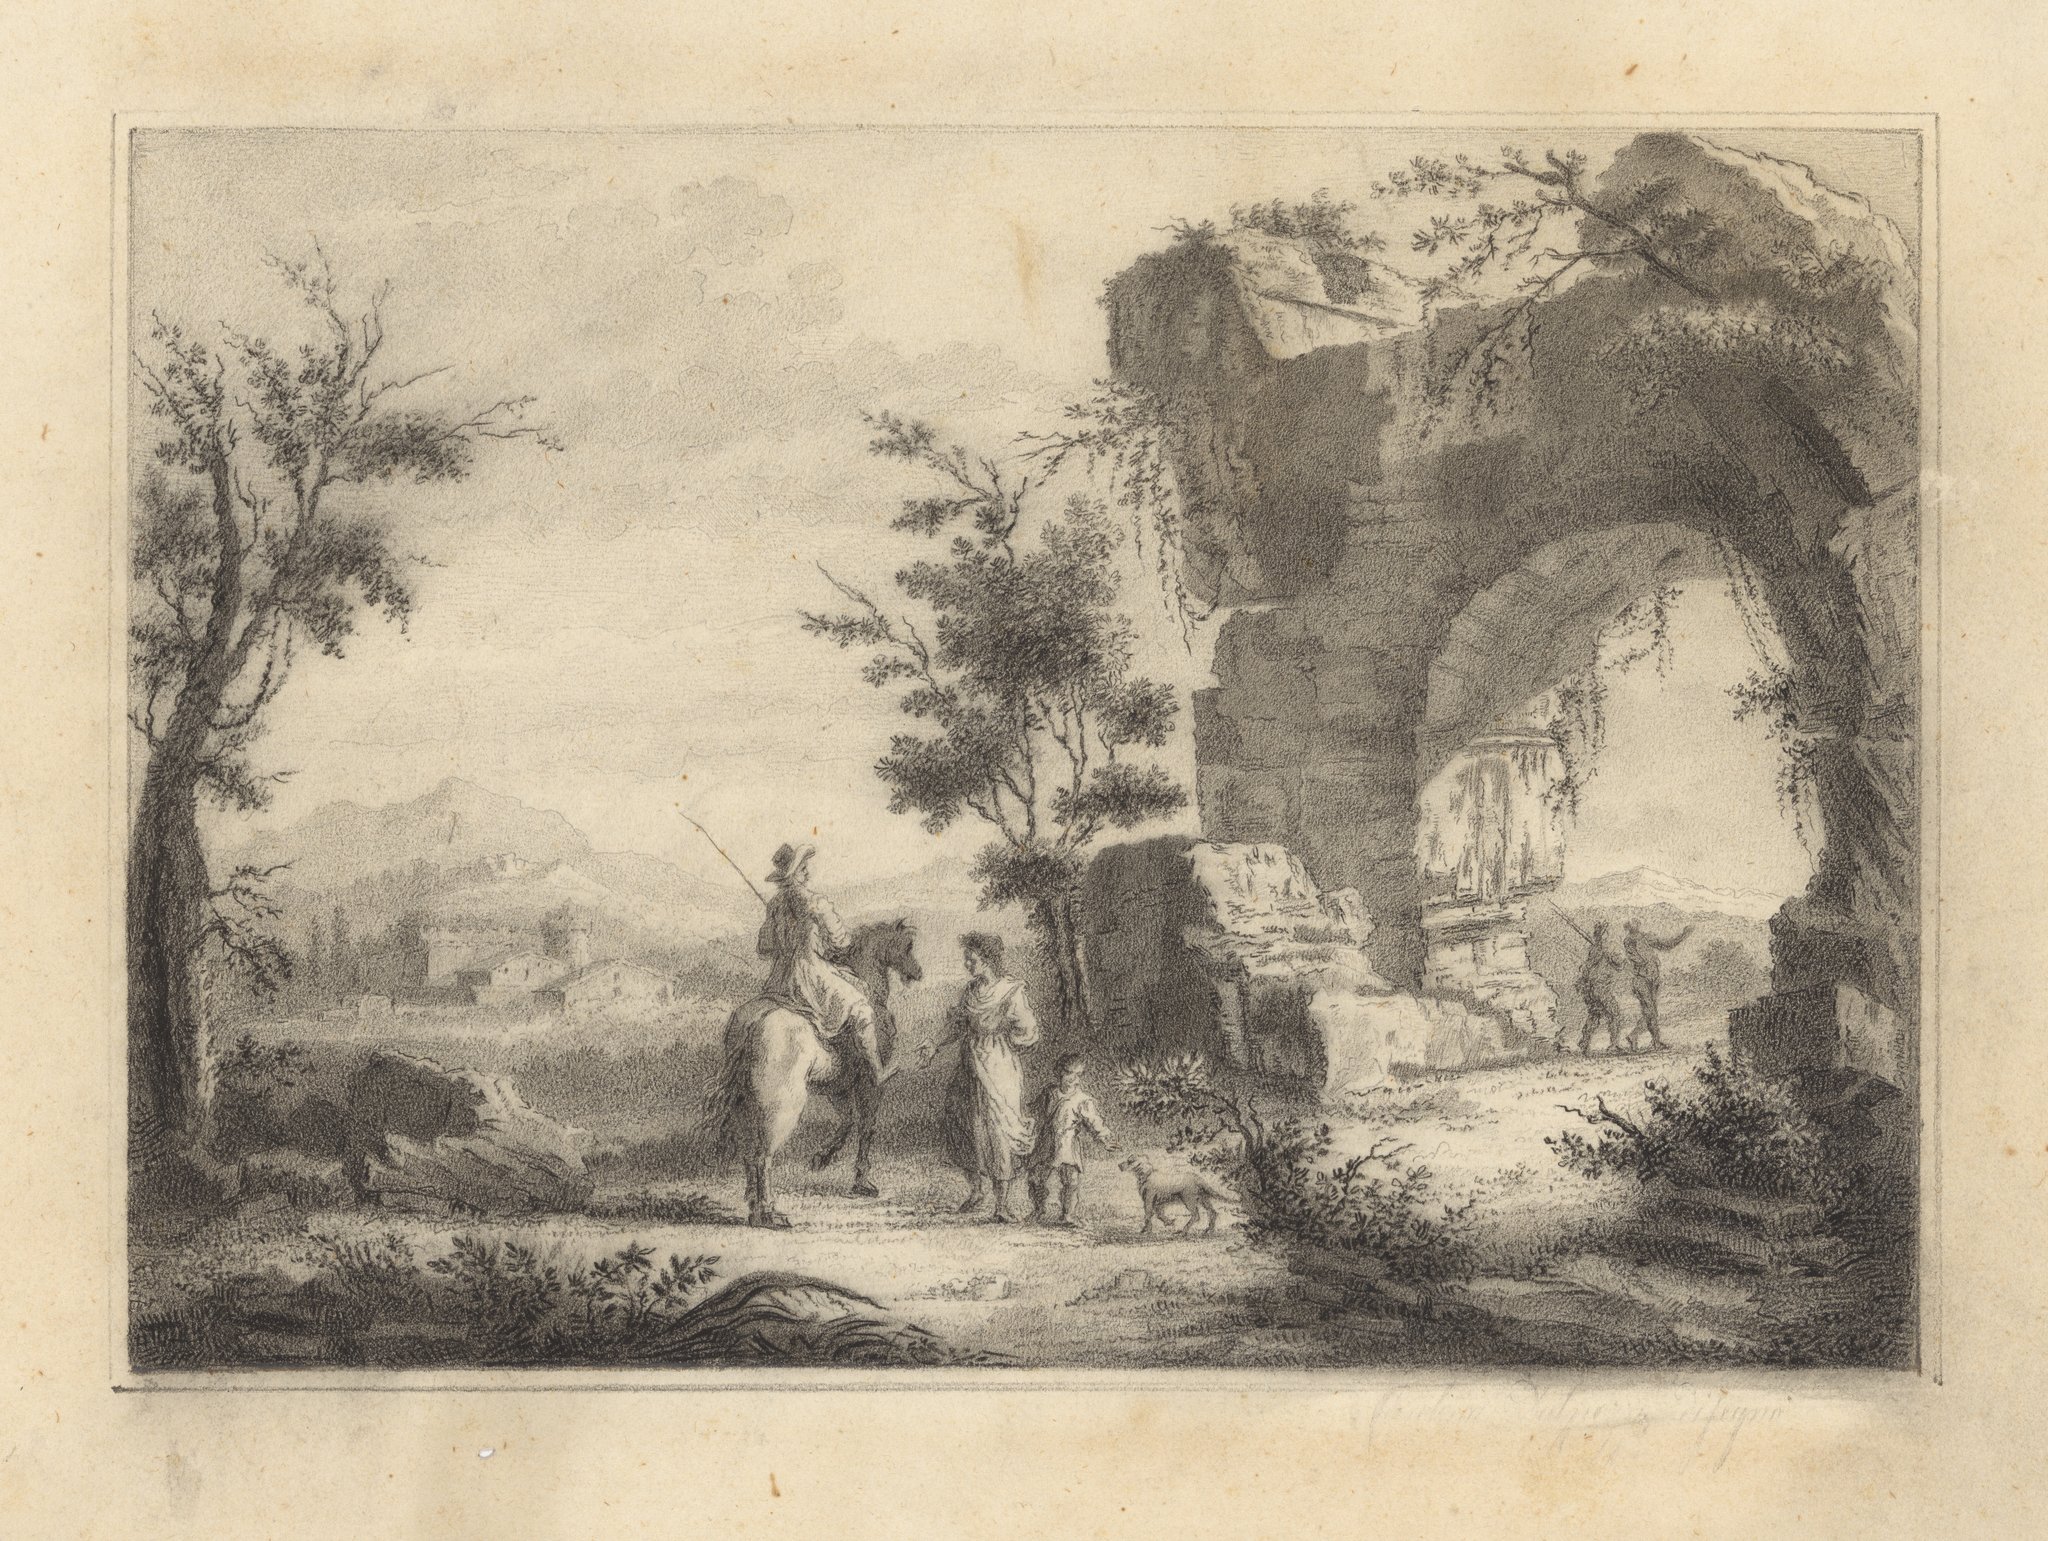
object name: drawing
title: Landscape with Ruined Architecture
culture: italian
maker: school of zuccarelli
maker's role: artist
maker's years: 1702-1788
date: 1734-1866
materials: chalk, charcoal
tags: ruins,men,women,horses,landscapes